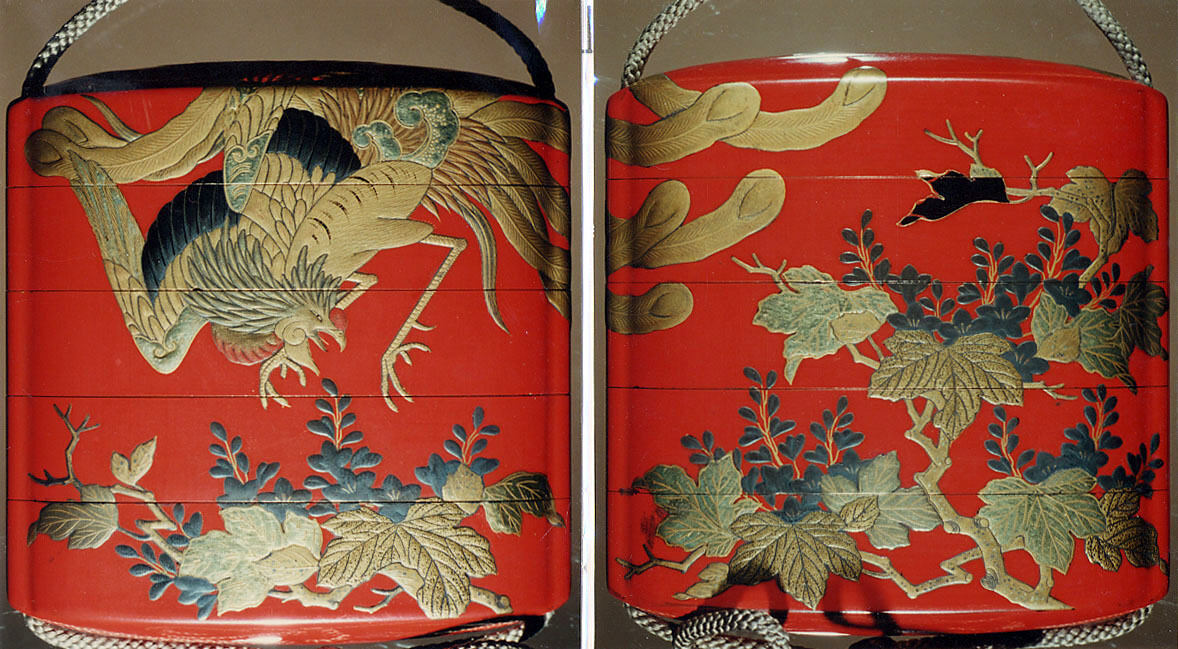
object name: inrō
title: Case (Inrō) with Design of Hō-ō Bird in Flight above Flowering Kiri Branches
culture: japanese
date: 1801-1900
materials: gold, lacquer, silver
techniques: fundame, hiramakie, maki-e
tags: birds,flowers